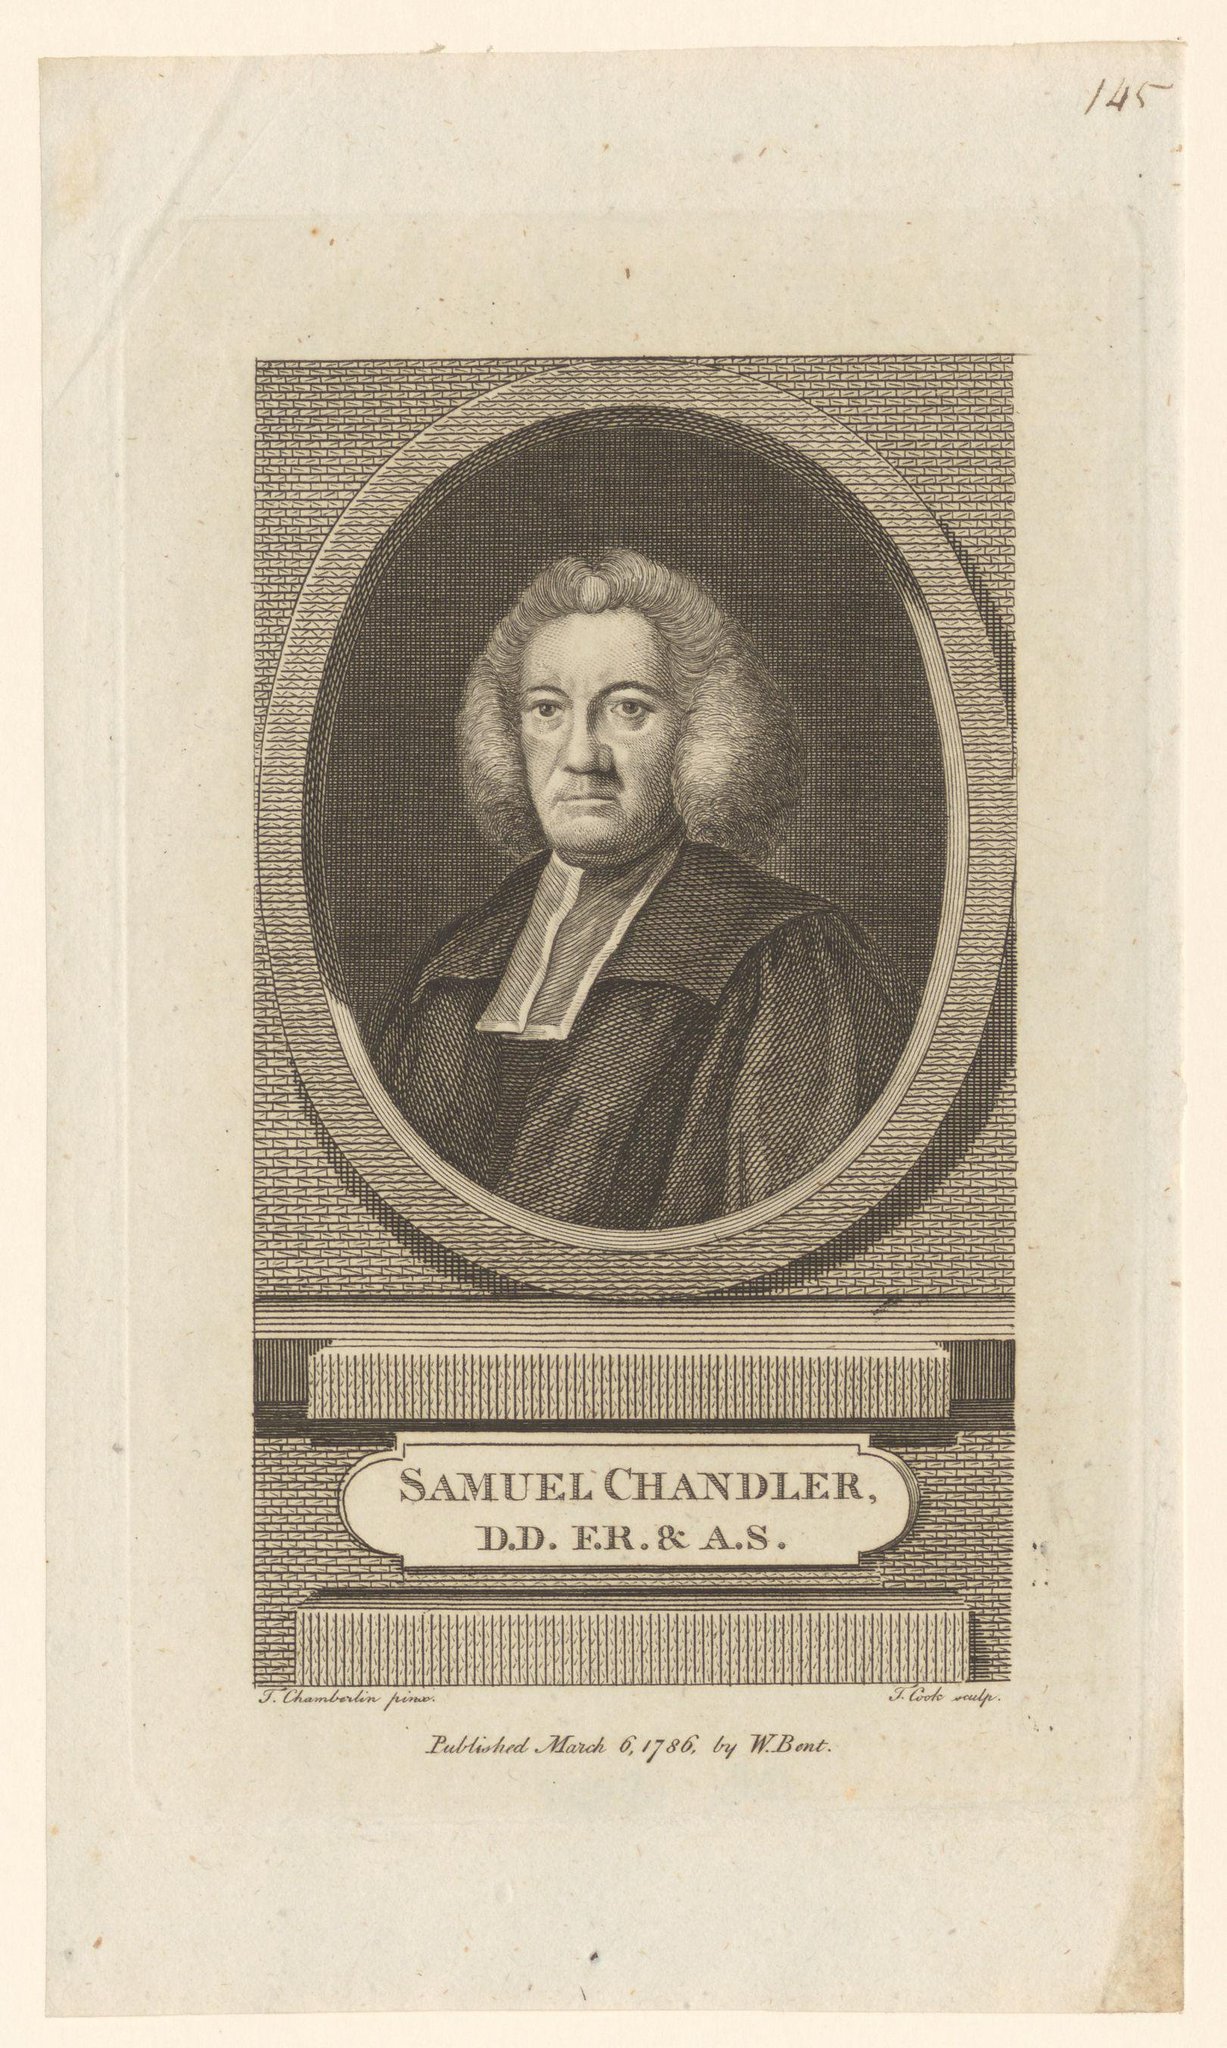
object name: print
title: Portret van Samuel Chandler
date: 1786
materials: paper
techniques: engraving, etching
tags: london, historical persons, politician, e.g. party leader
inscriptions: number: ‘145’, collector's mark: Lugt 2228